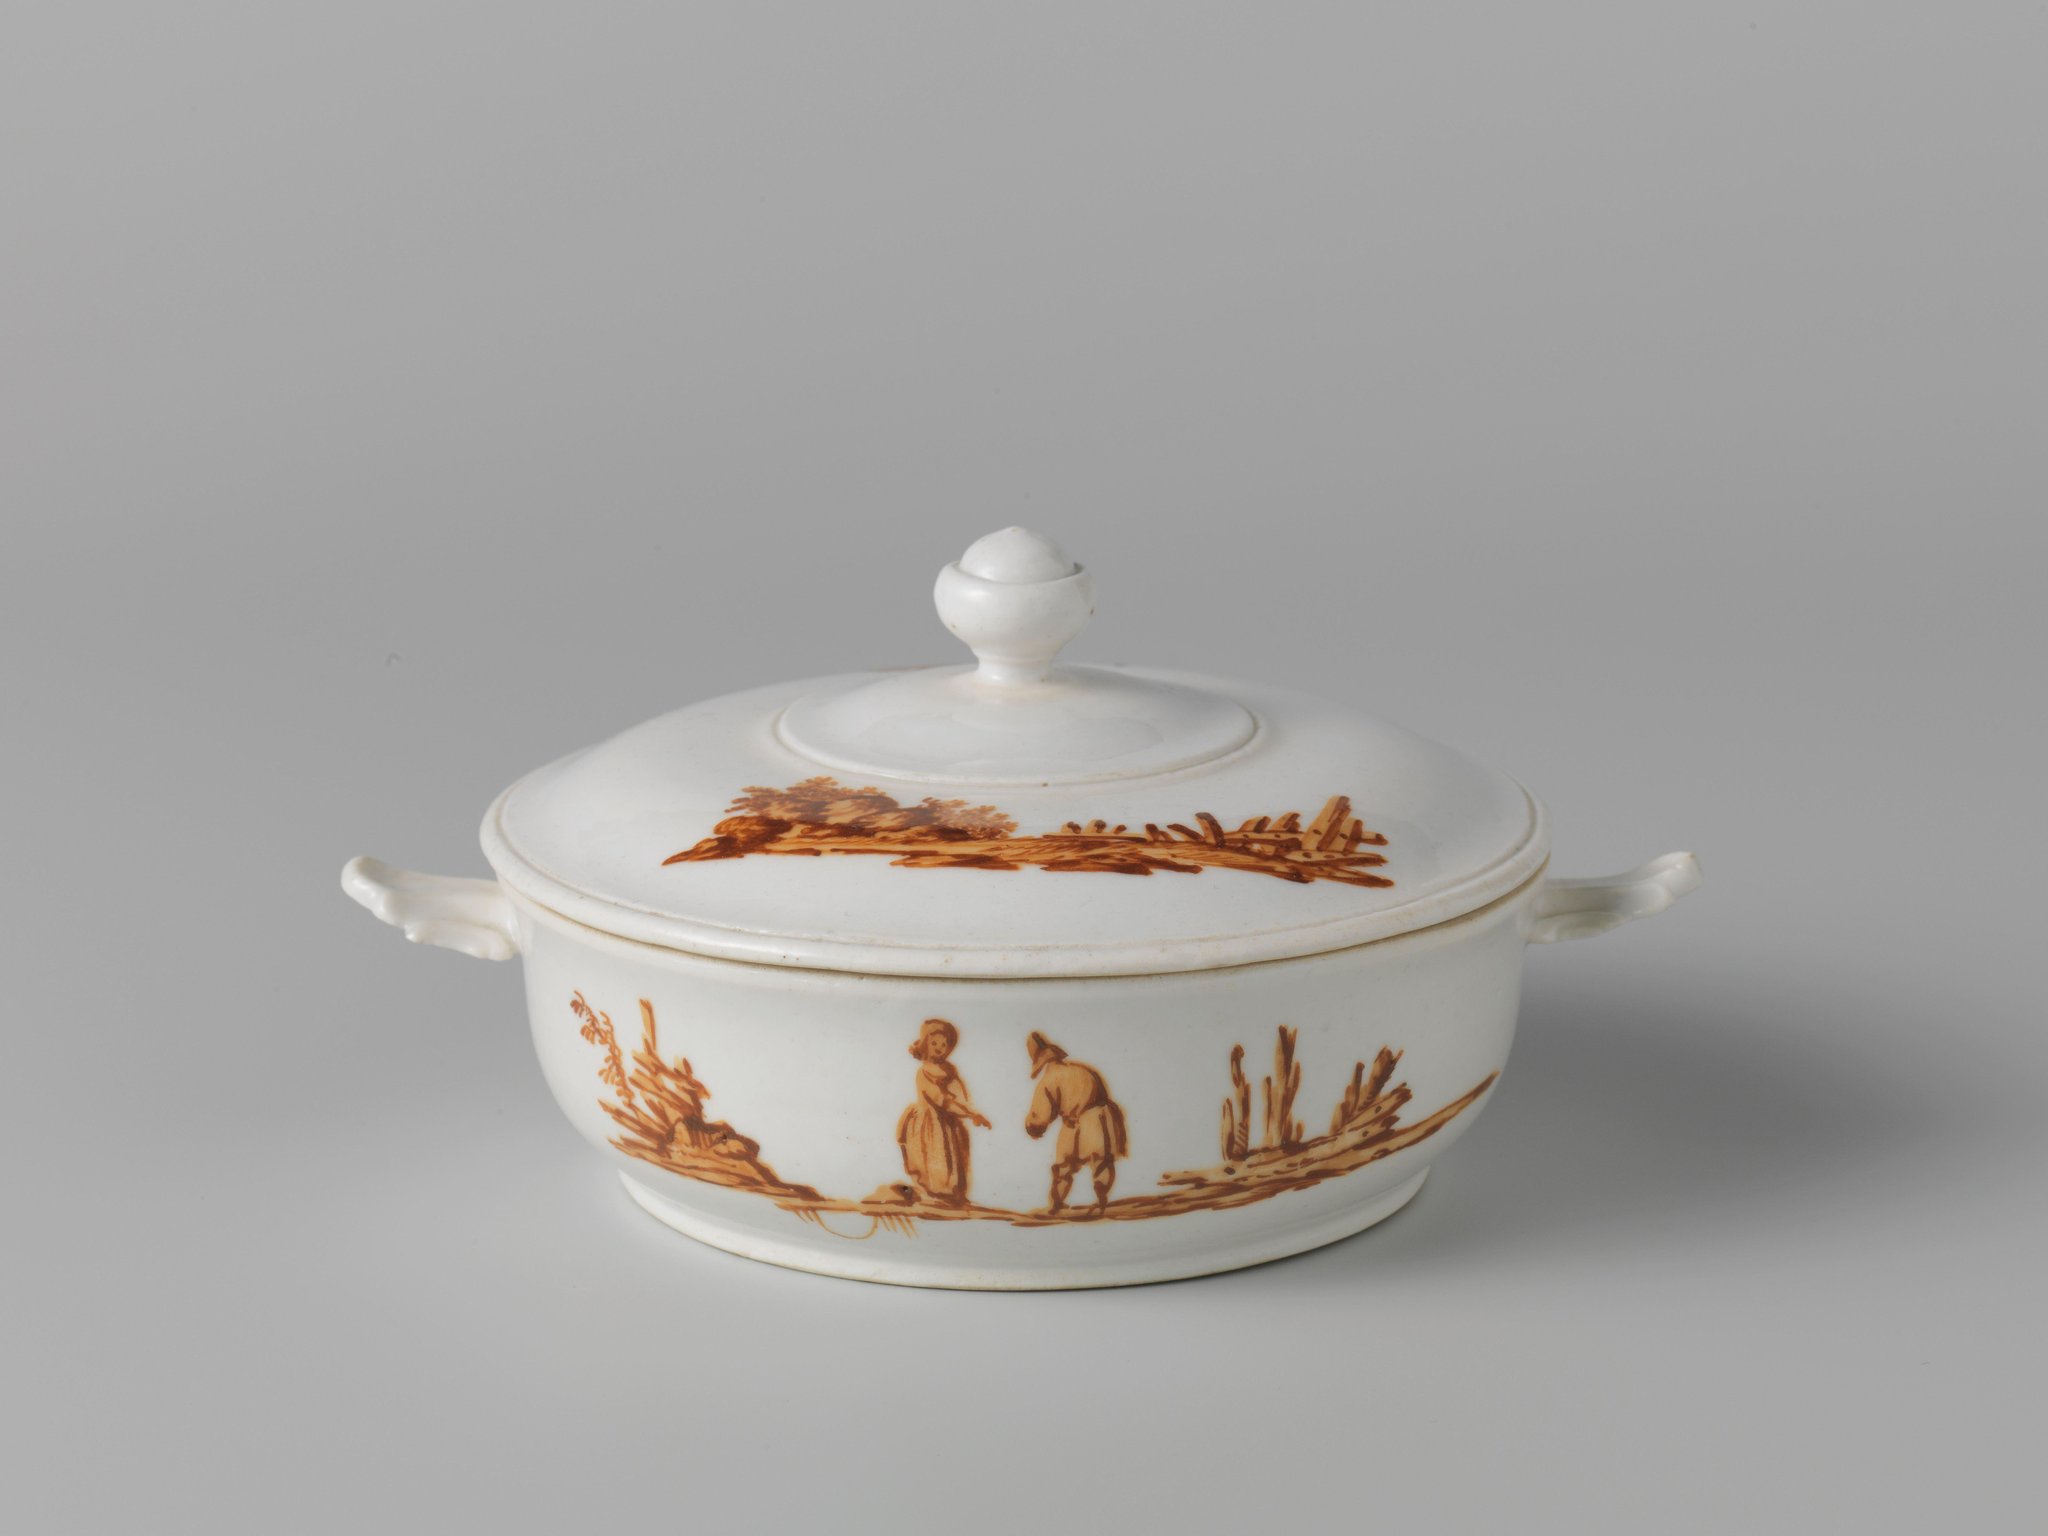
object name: butter dish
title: Botervloot, beschilderd met landschappen met figuren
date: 1774-1778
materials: porcelain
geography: loosdrecht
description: Botervloot van porselein. Licht gewelfde gladde wand. De oren in de vorm van een liggend acanthusblad. Aan beide zijden van de vloot en twee maal op de deksels een landschapsgrondje in sepia zonder, met één of met twee figuren.